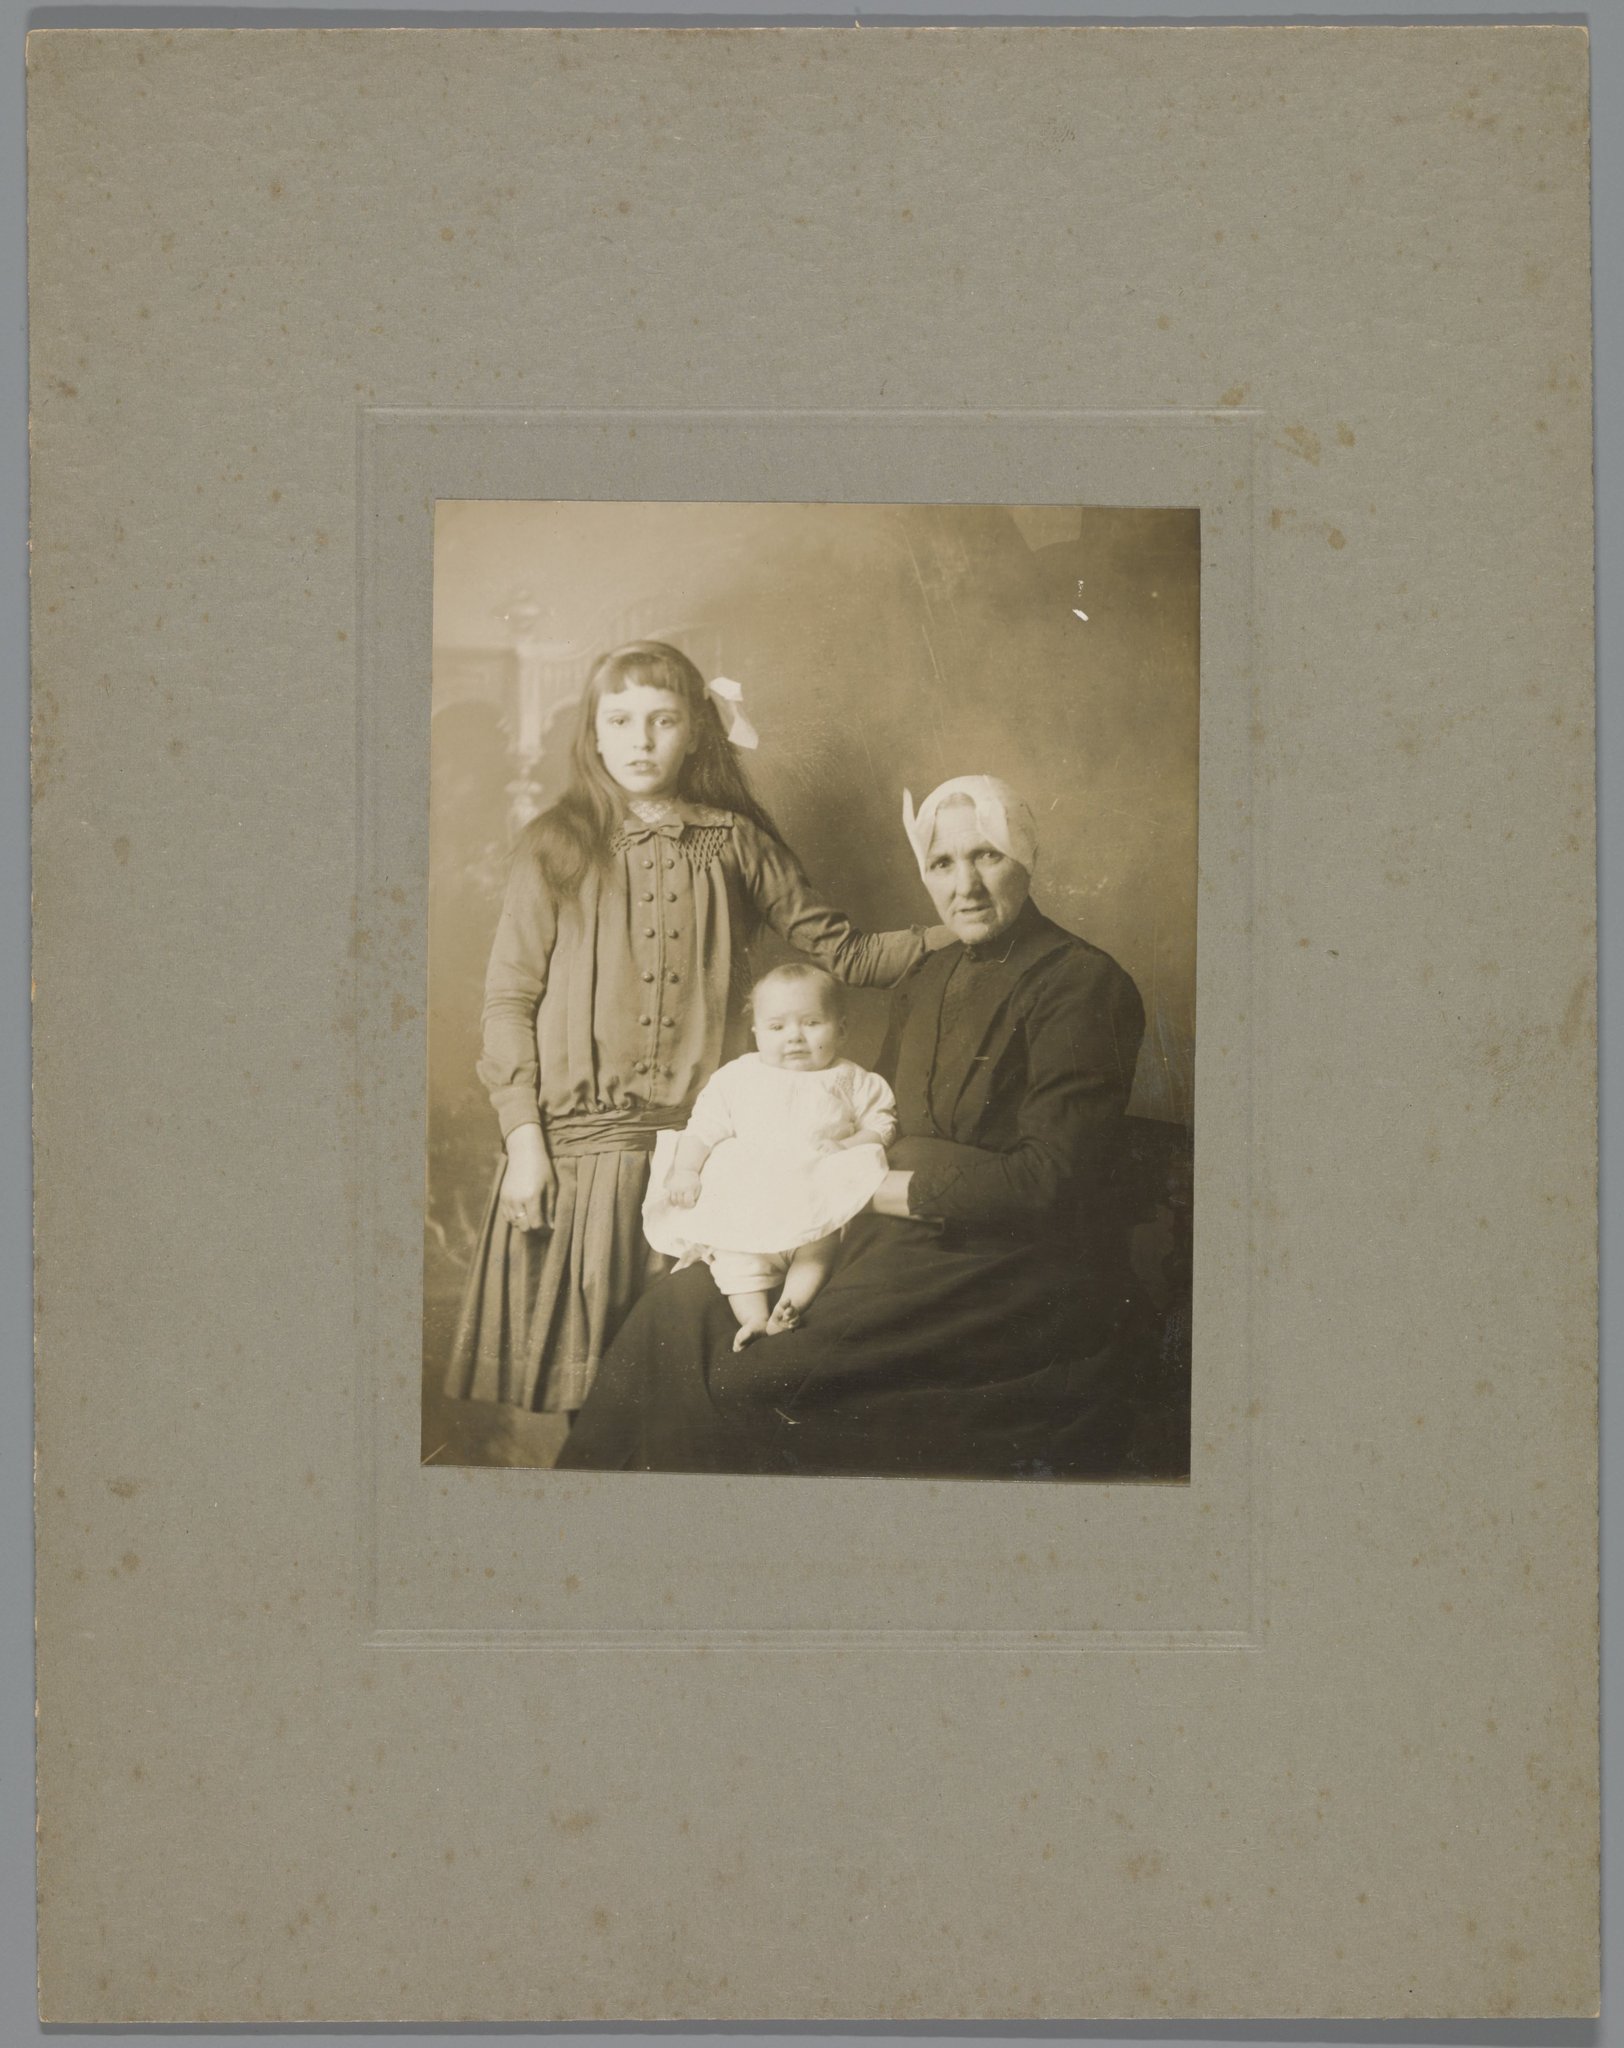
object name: photograph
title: Vrouw met twee kinderen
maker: willem witsen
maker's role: draughtsman, painter, print maker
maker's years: 1860-1923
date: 1860-1915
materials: cardboard, paper, photographic support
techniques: gelatin silver print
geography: netherlands